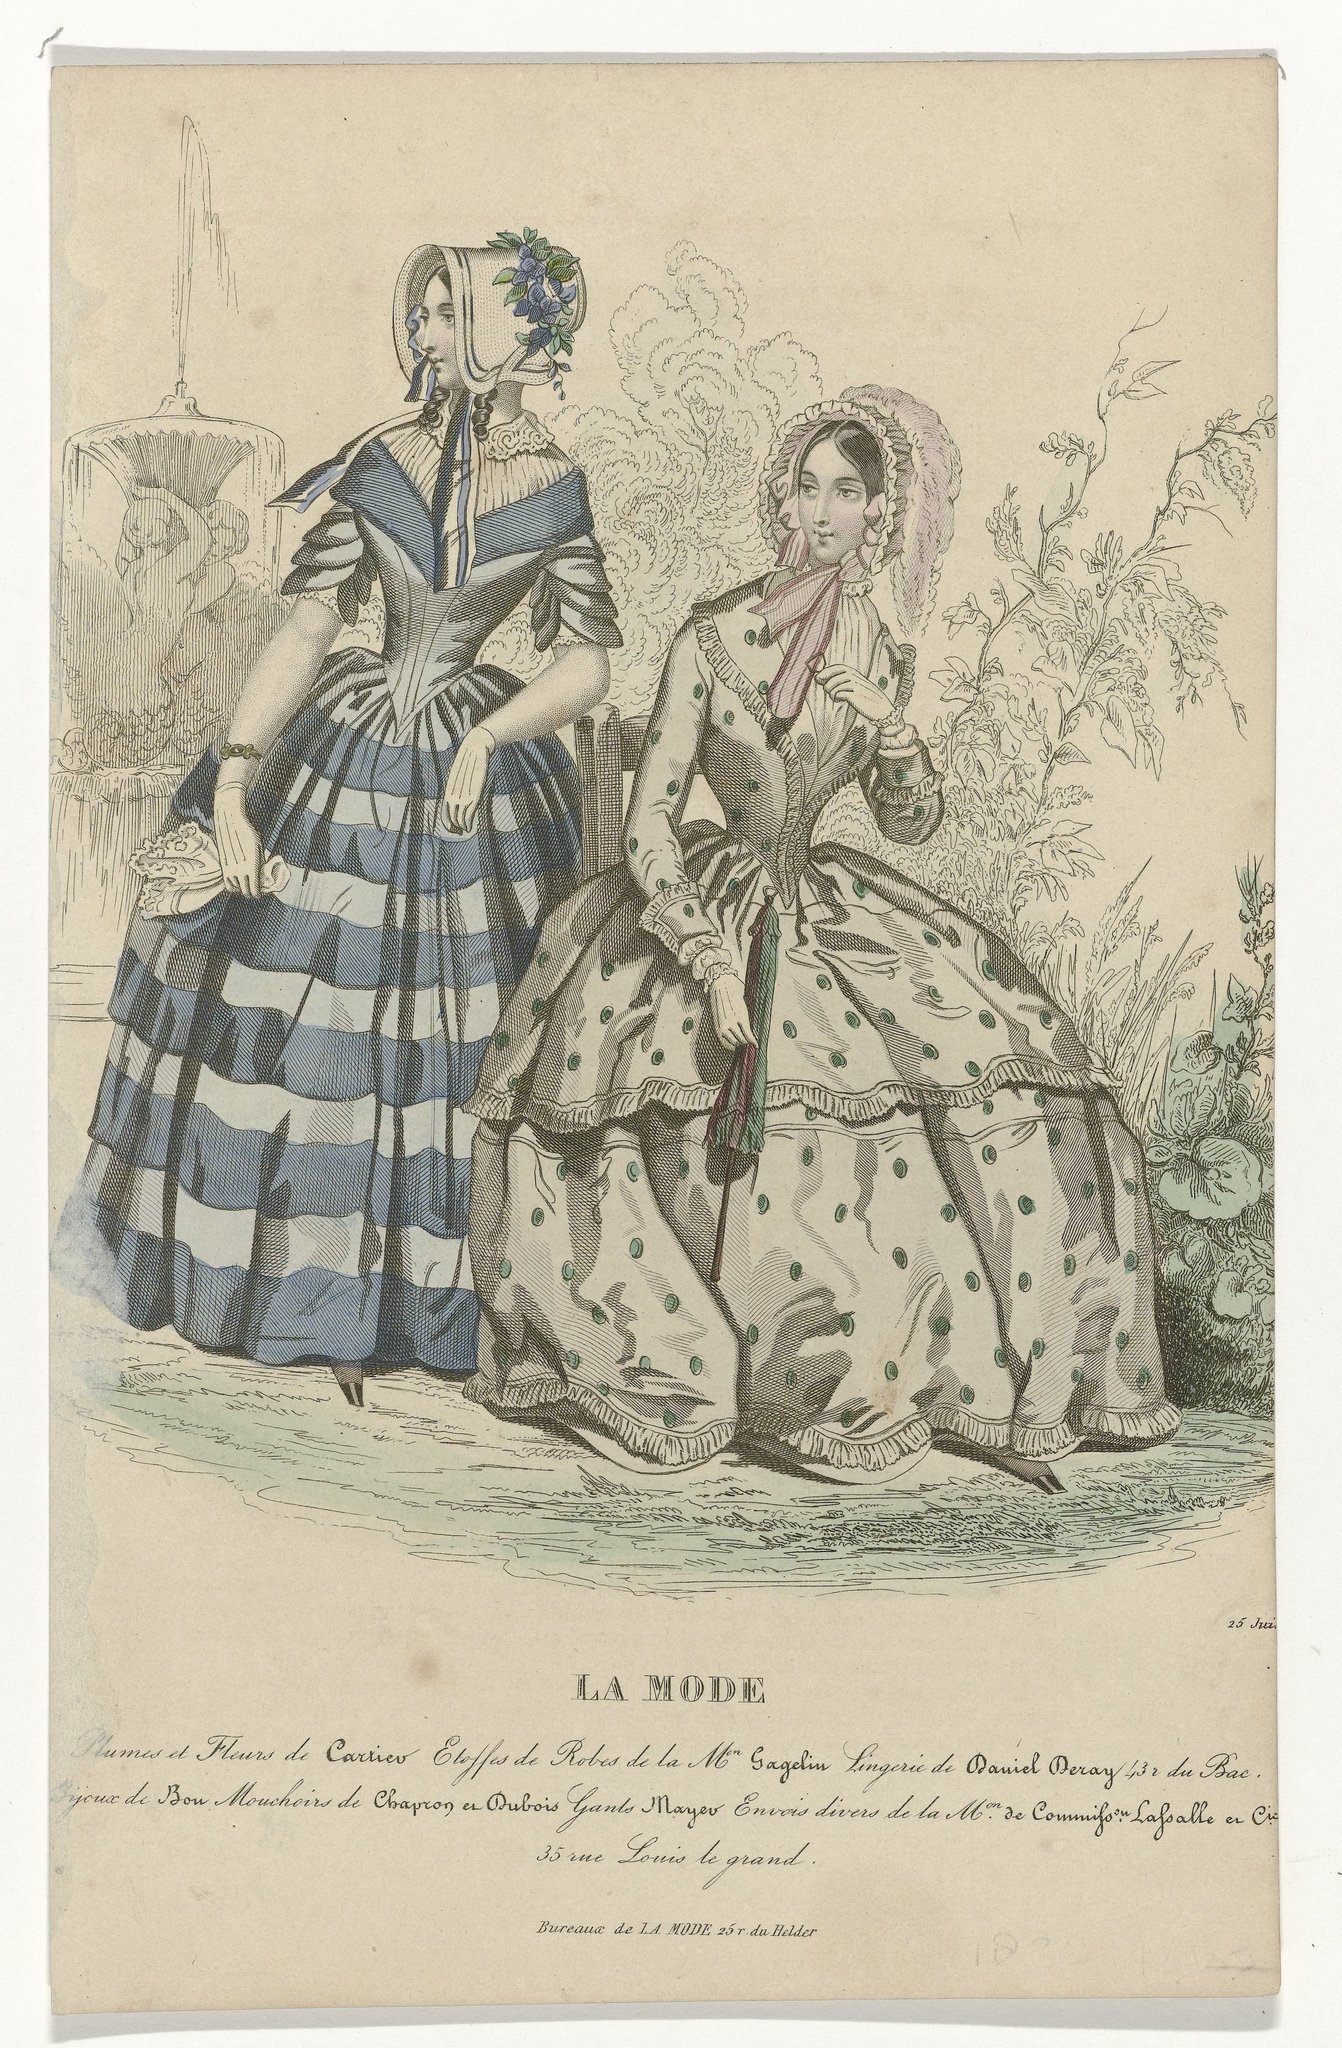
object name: fashion print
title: La Mode, 25 juin 1844 : Plumes et Fleurs (...)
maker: Anonymous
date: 1844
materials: paper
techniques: engraving, hand coloring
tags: handkerchief (+ women's clothes), monocle, single lorgnette - aa - female human figure, garden fountain, fashion plates, head-gear: hat (+ women's clothes), shoes, sandals (+ women's clothes), gloves, mittens, etc. (+ women's clothes), dress, gown (+ women's clothes), neck-gear ~ clothing (+ women's clothes), bracelet, wristlet (+ women's clothes), parasol, sunshade (+ women's clothes)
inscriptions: address: ‘Bureaux de La Mode 25 r. du Helder’, title: ‘La Mode’, caption: ‘Plumes et Fleurs de Cartier Etoffes de Robes de la Mon Gagelin Lingerie de Daniel Deray 43 r du Bac. Bÿoux de Bou Mouchoirs de Chapron en Dubois Gants Mayer Envois divers de la M.on de Commiss.on Lassalle et Cie 35 rue Louis le grand.’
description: Twee vrouwen in een tuin, op de achtergrond een fontein. Links: japon met korte mouwen, puntig lijfje en wijde rok met blauw strepenmotief. Accessoires: luifelhoed met gestreepte striklinten en versierd met bloemen, korte handschoenen, zakdoek, armband. Rechts: japon met lange mouwen en wijde rok met groen stippenmotief. Sjaalkraag, manchetten en rok versierd met ruches. Poffende ondermouwen. Accessories: luifelhoed met afhangende veer en striklinten, lorgnet, handschoenen, parasol. Onder de voorstelling enkele regels reclametekst voor verschillende producten. Prent uit het modetijdschrift La Mode (1829-1855).